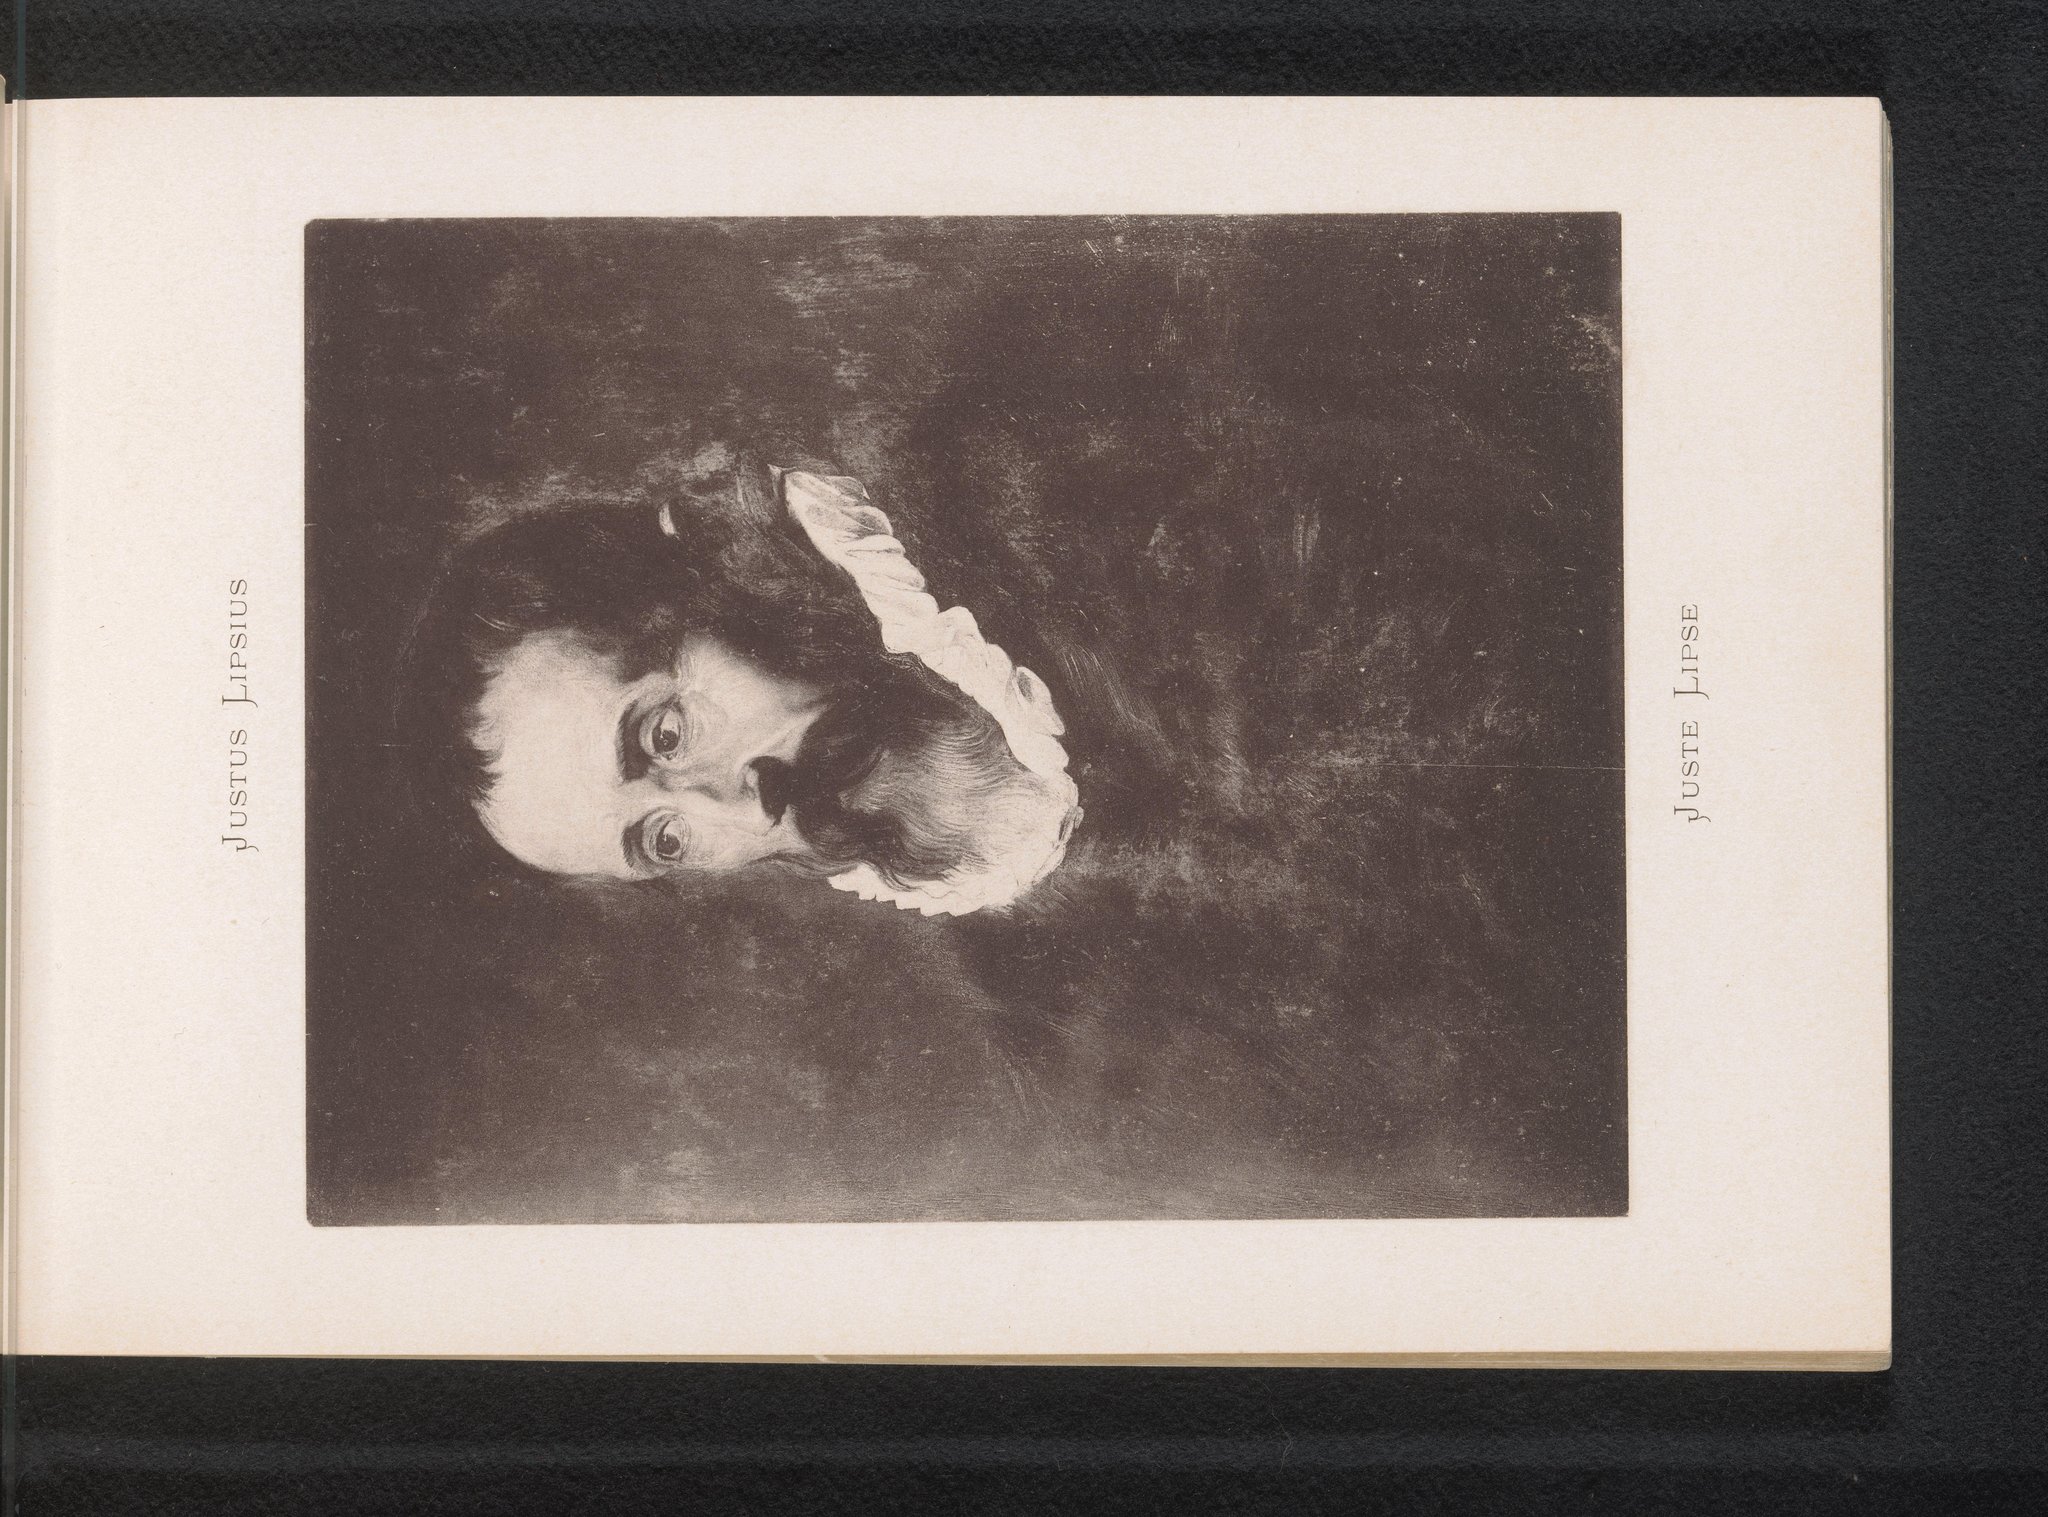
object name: reproduction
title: Reproductie van een geschilderd portret van Justus Lipsius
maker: Anonymous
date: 1892-1897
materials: paper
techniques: photograph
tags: louvain, justus lipsius, adult man